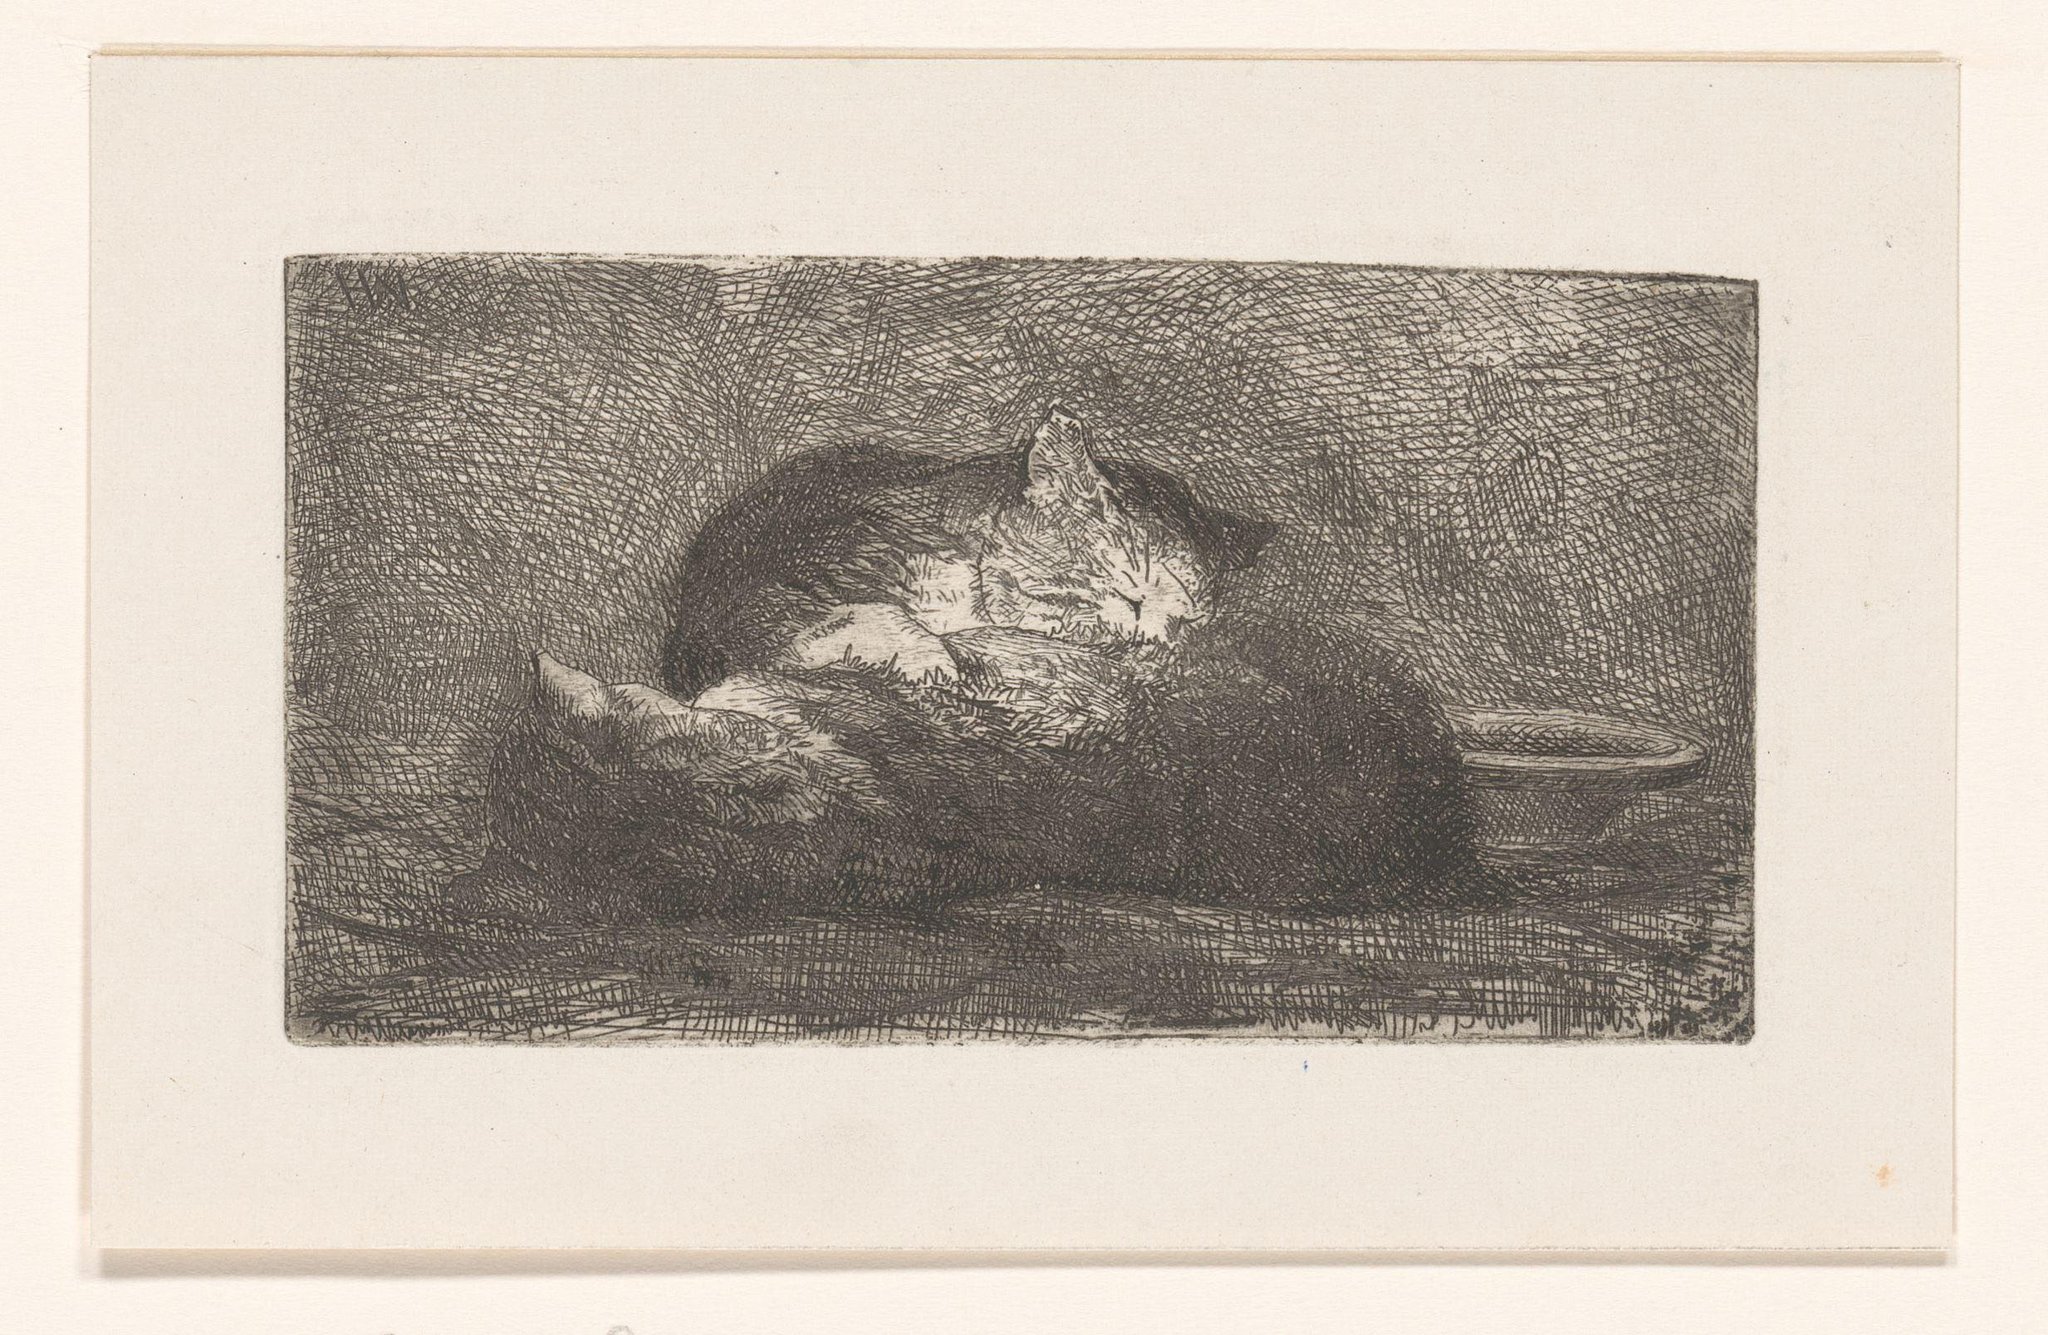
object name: print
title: Twee katten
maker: herman johannes van der weele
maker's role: print maker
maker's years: 1852-1930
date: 1862-1930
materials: paper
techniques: etching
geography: netherlands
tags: cat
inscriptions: collector's mark: Lugt 2228, inscription: ‘2e dr.’